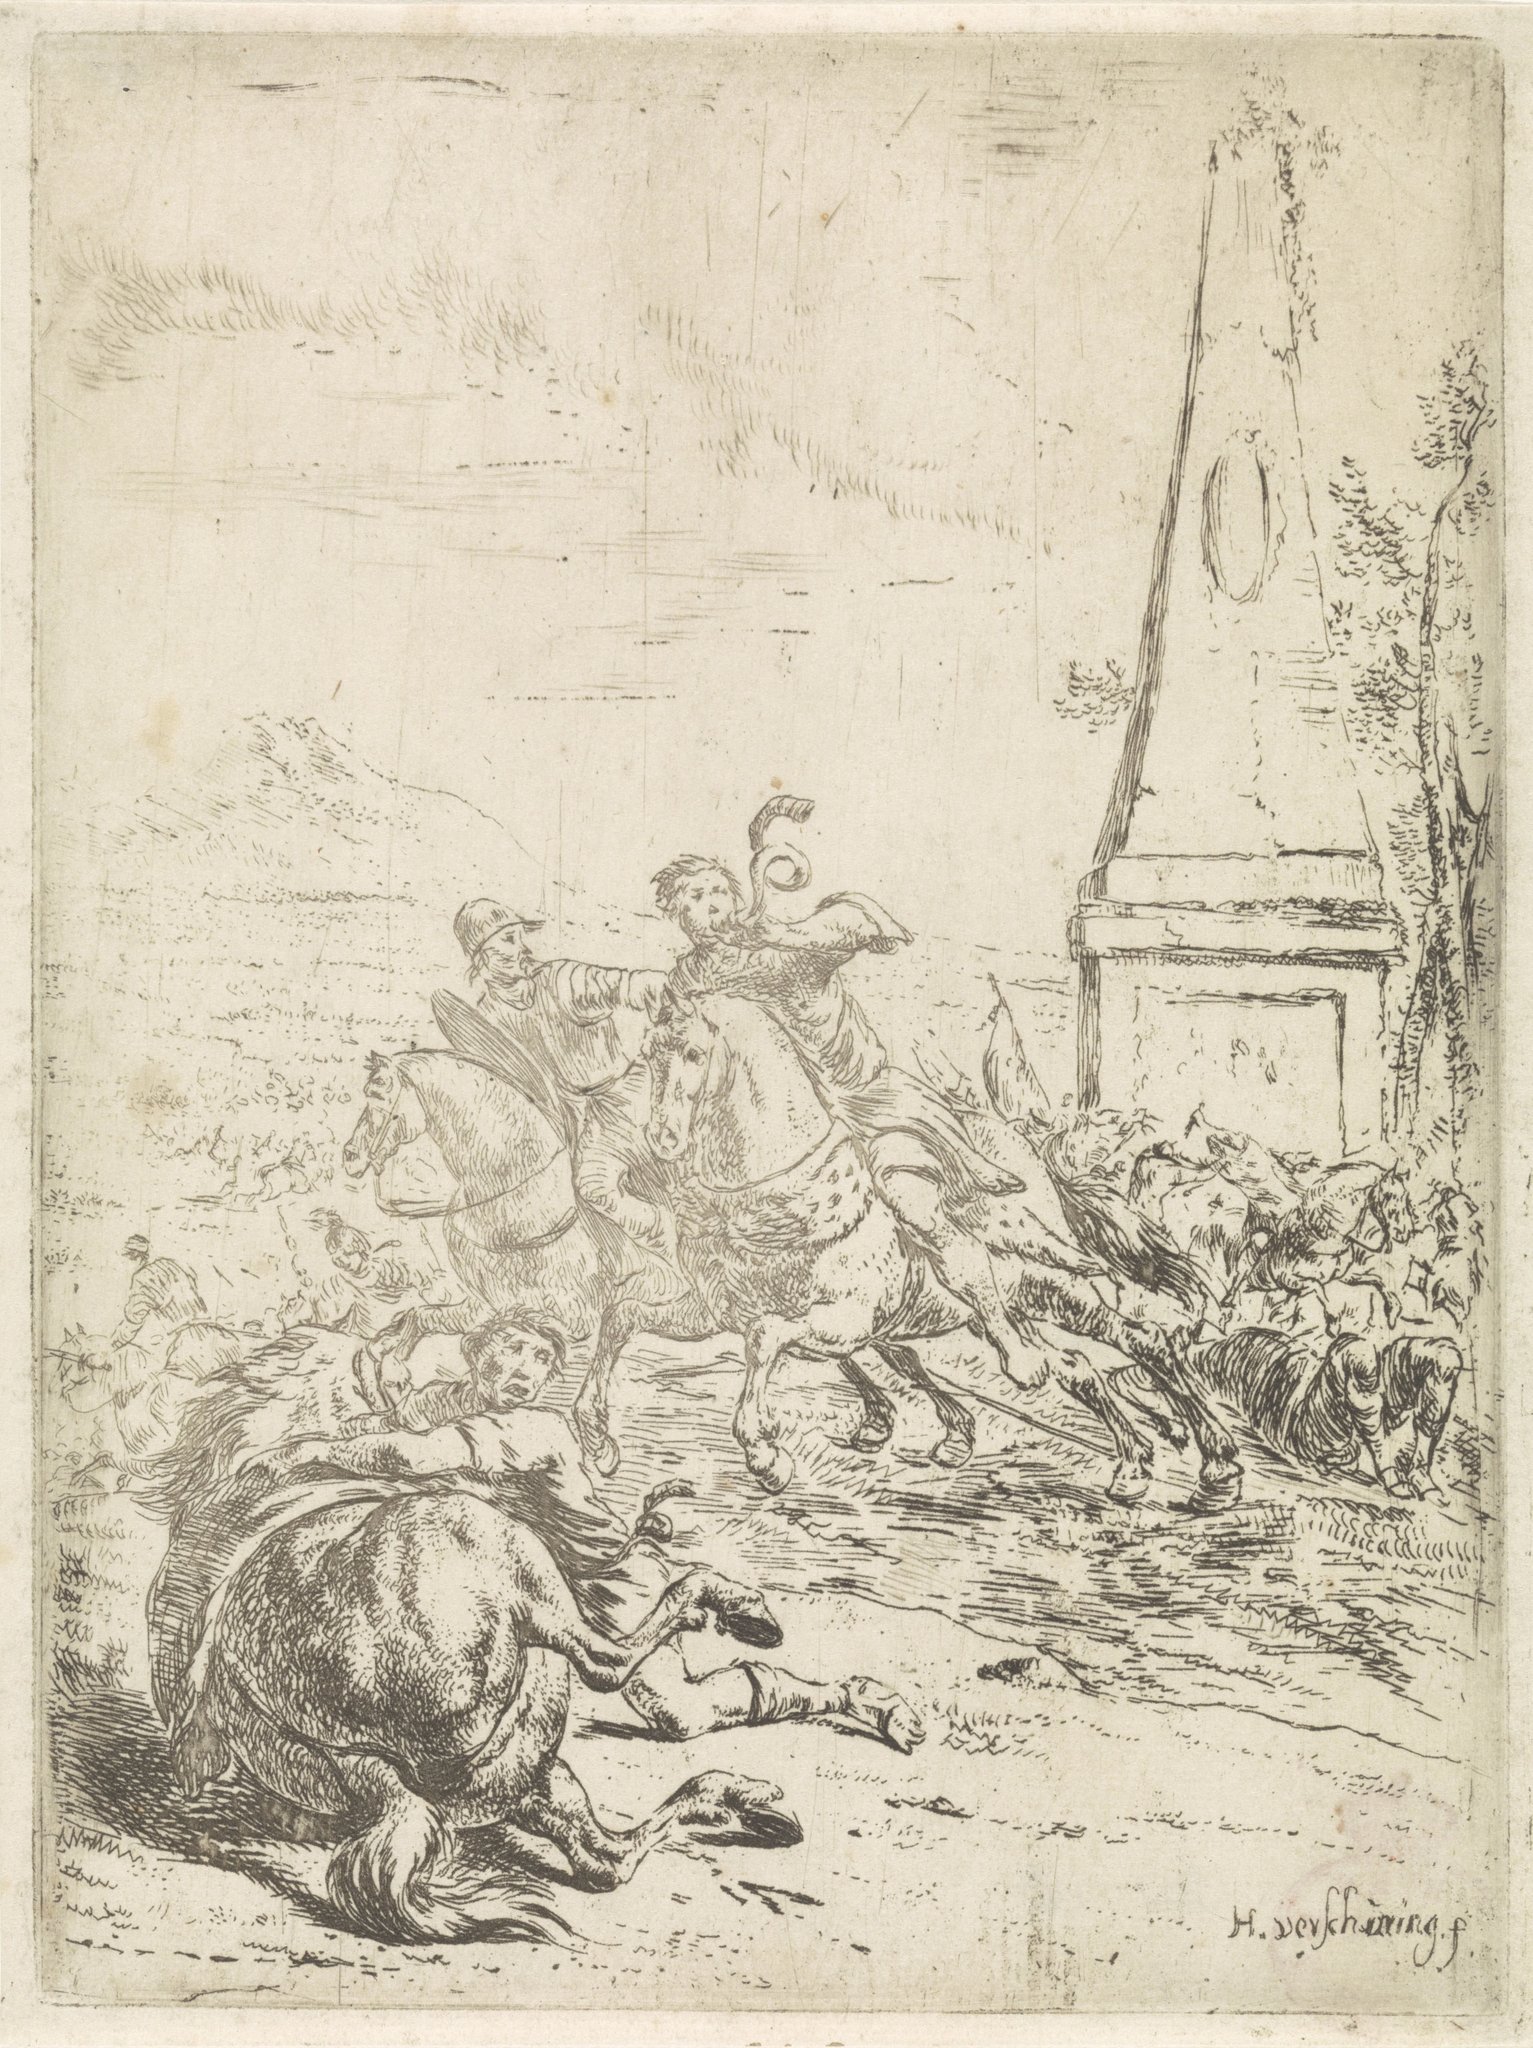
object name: print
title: Cavaleriegevecht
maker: hendrik verschuring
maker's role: draughtsman, print maker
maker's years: 1627-1690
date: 1635-1690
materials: paper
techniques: etching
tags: obelisk, needle, battle (+ cavalry, horsemen)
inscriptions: collector's mark: ‘F. Rechberger 1800’ Lugt 2133, collector's mark: Lugt 12